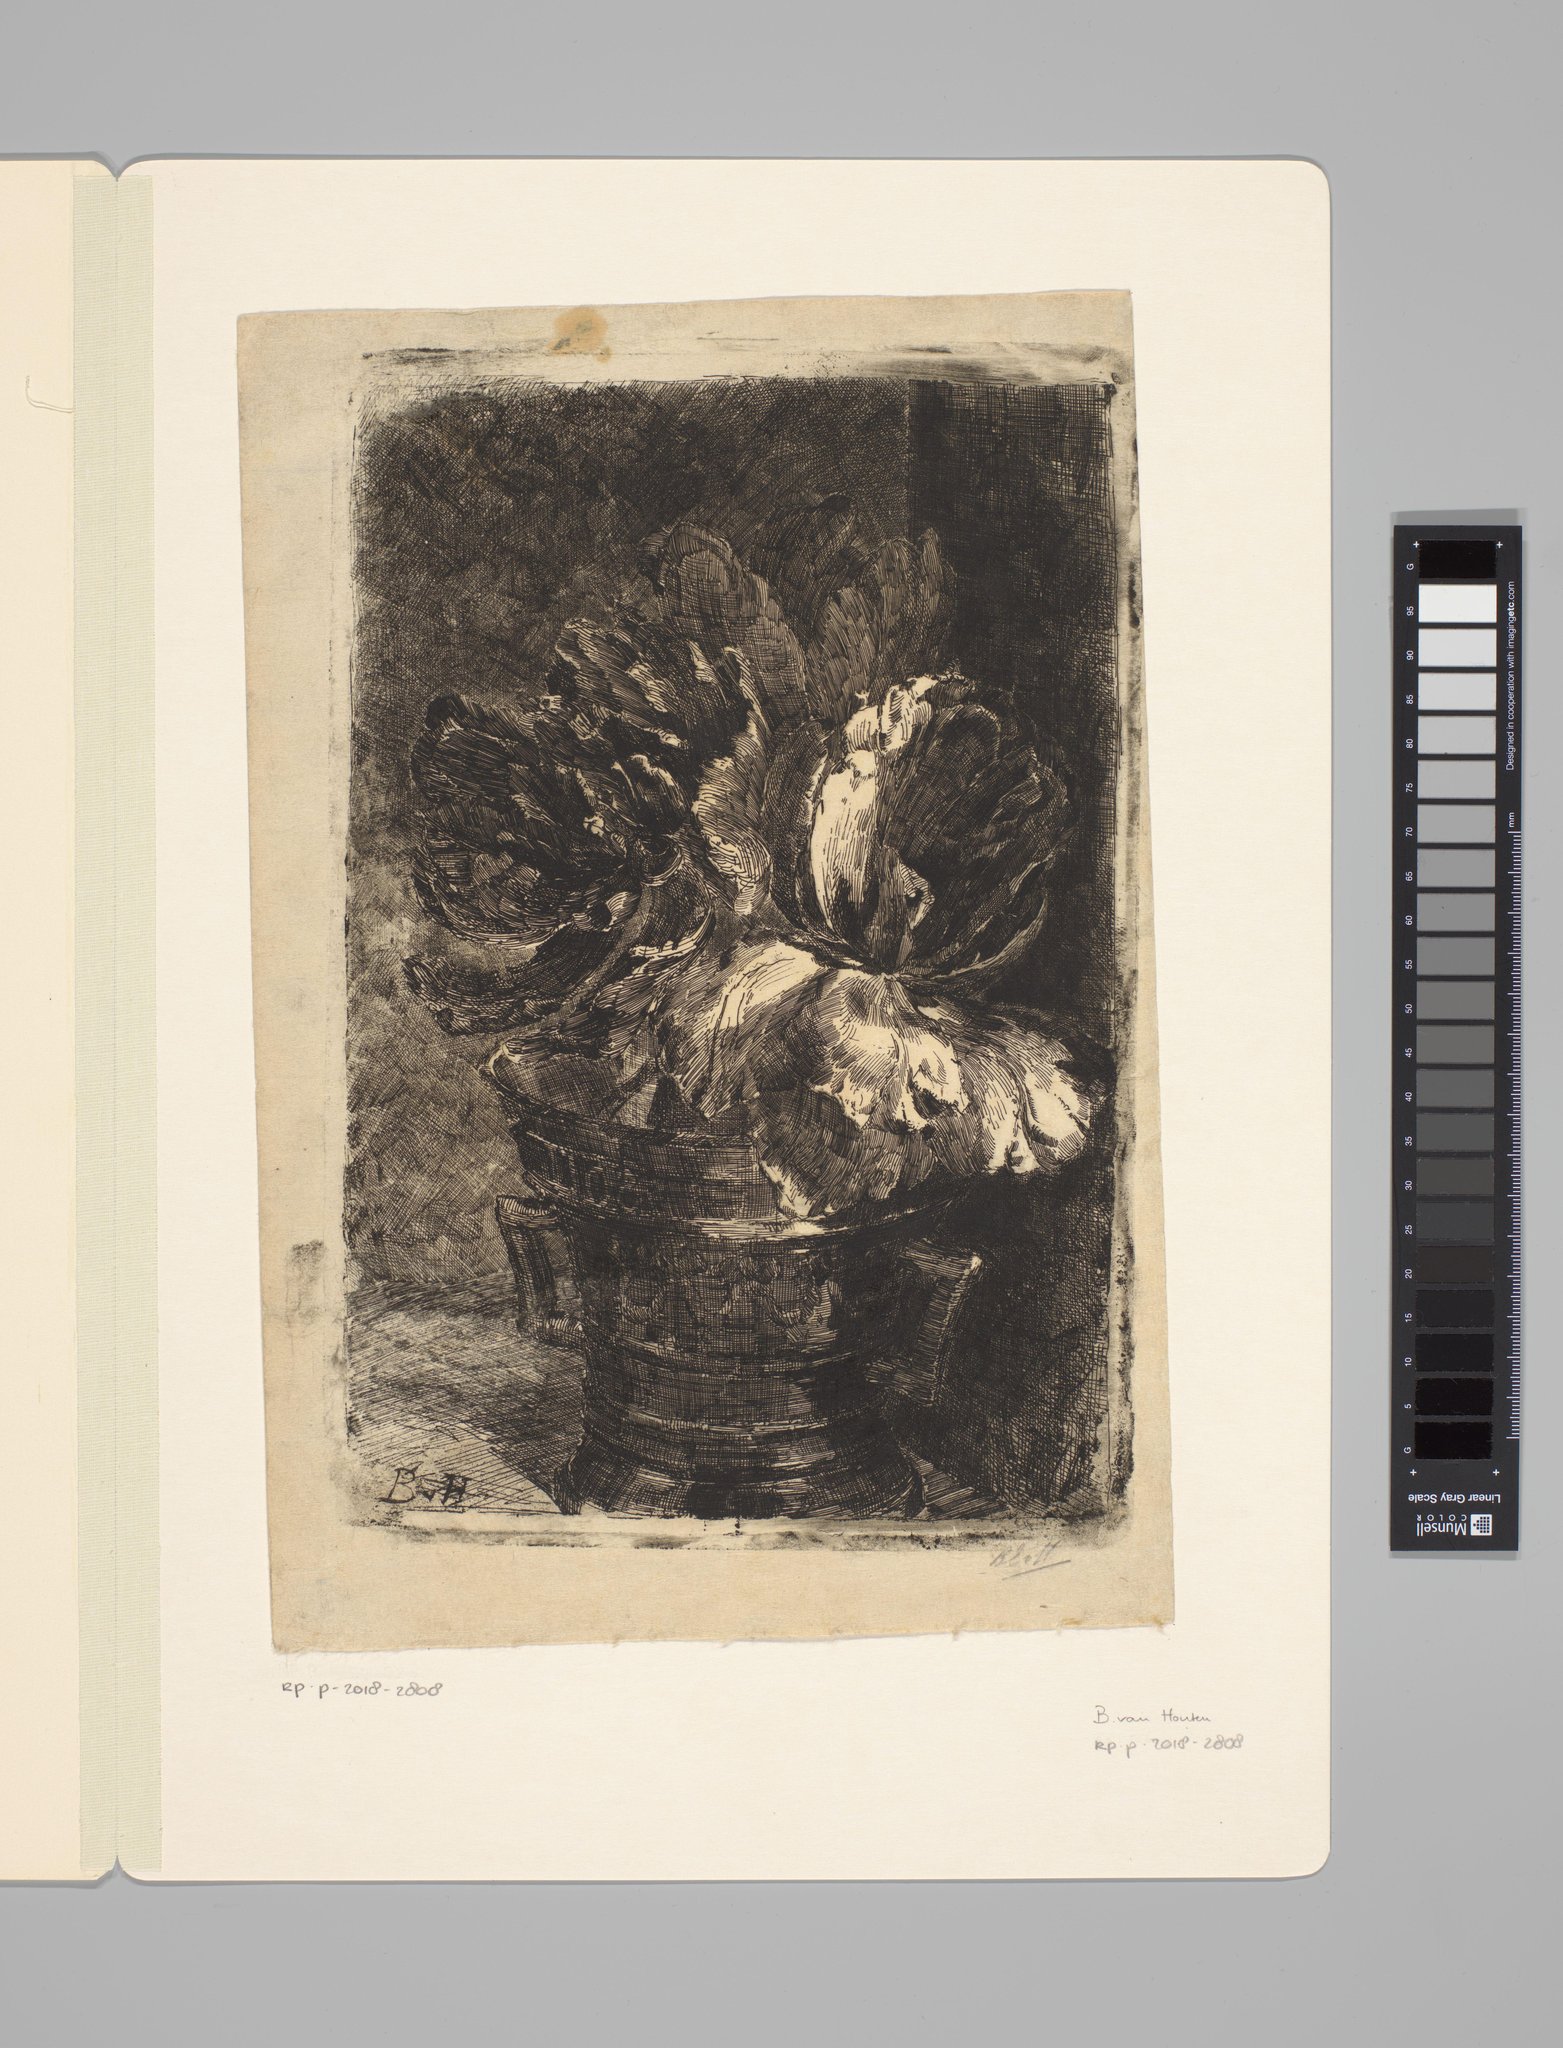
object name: print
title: Tulpen in koperen vijzel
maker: barbara elisabeth van houten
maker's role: draughtsman, print maker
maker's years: 1862-1950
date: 1877-1950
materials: paper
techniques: etching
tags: flowers: tulip, container of metal: bucket, can, canister, drum, tin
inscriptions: collector's mark: Lugt 2228